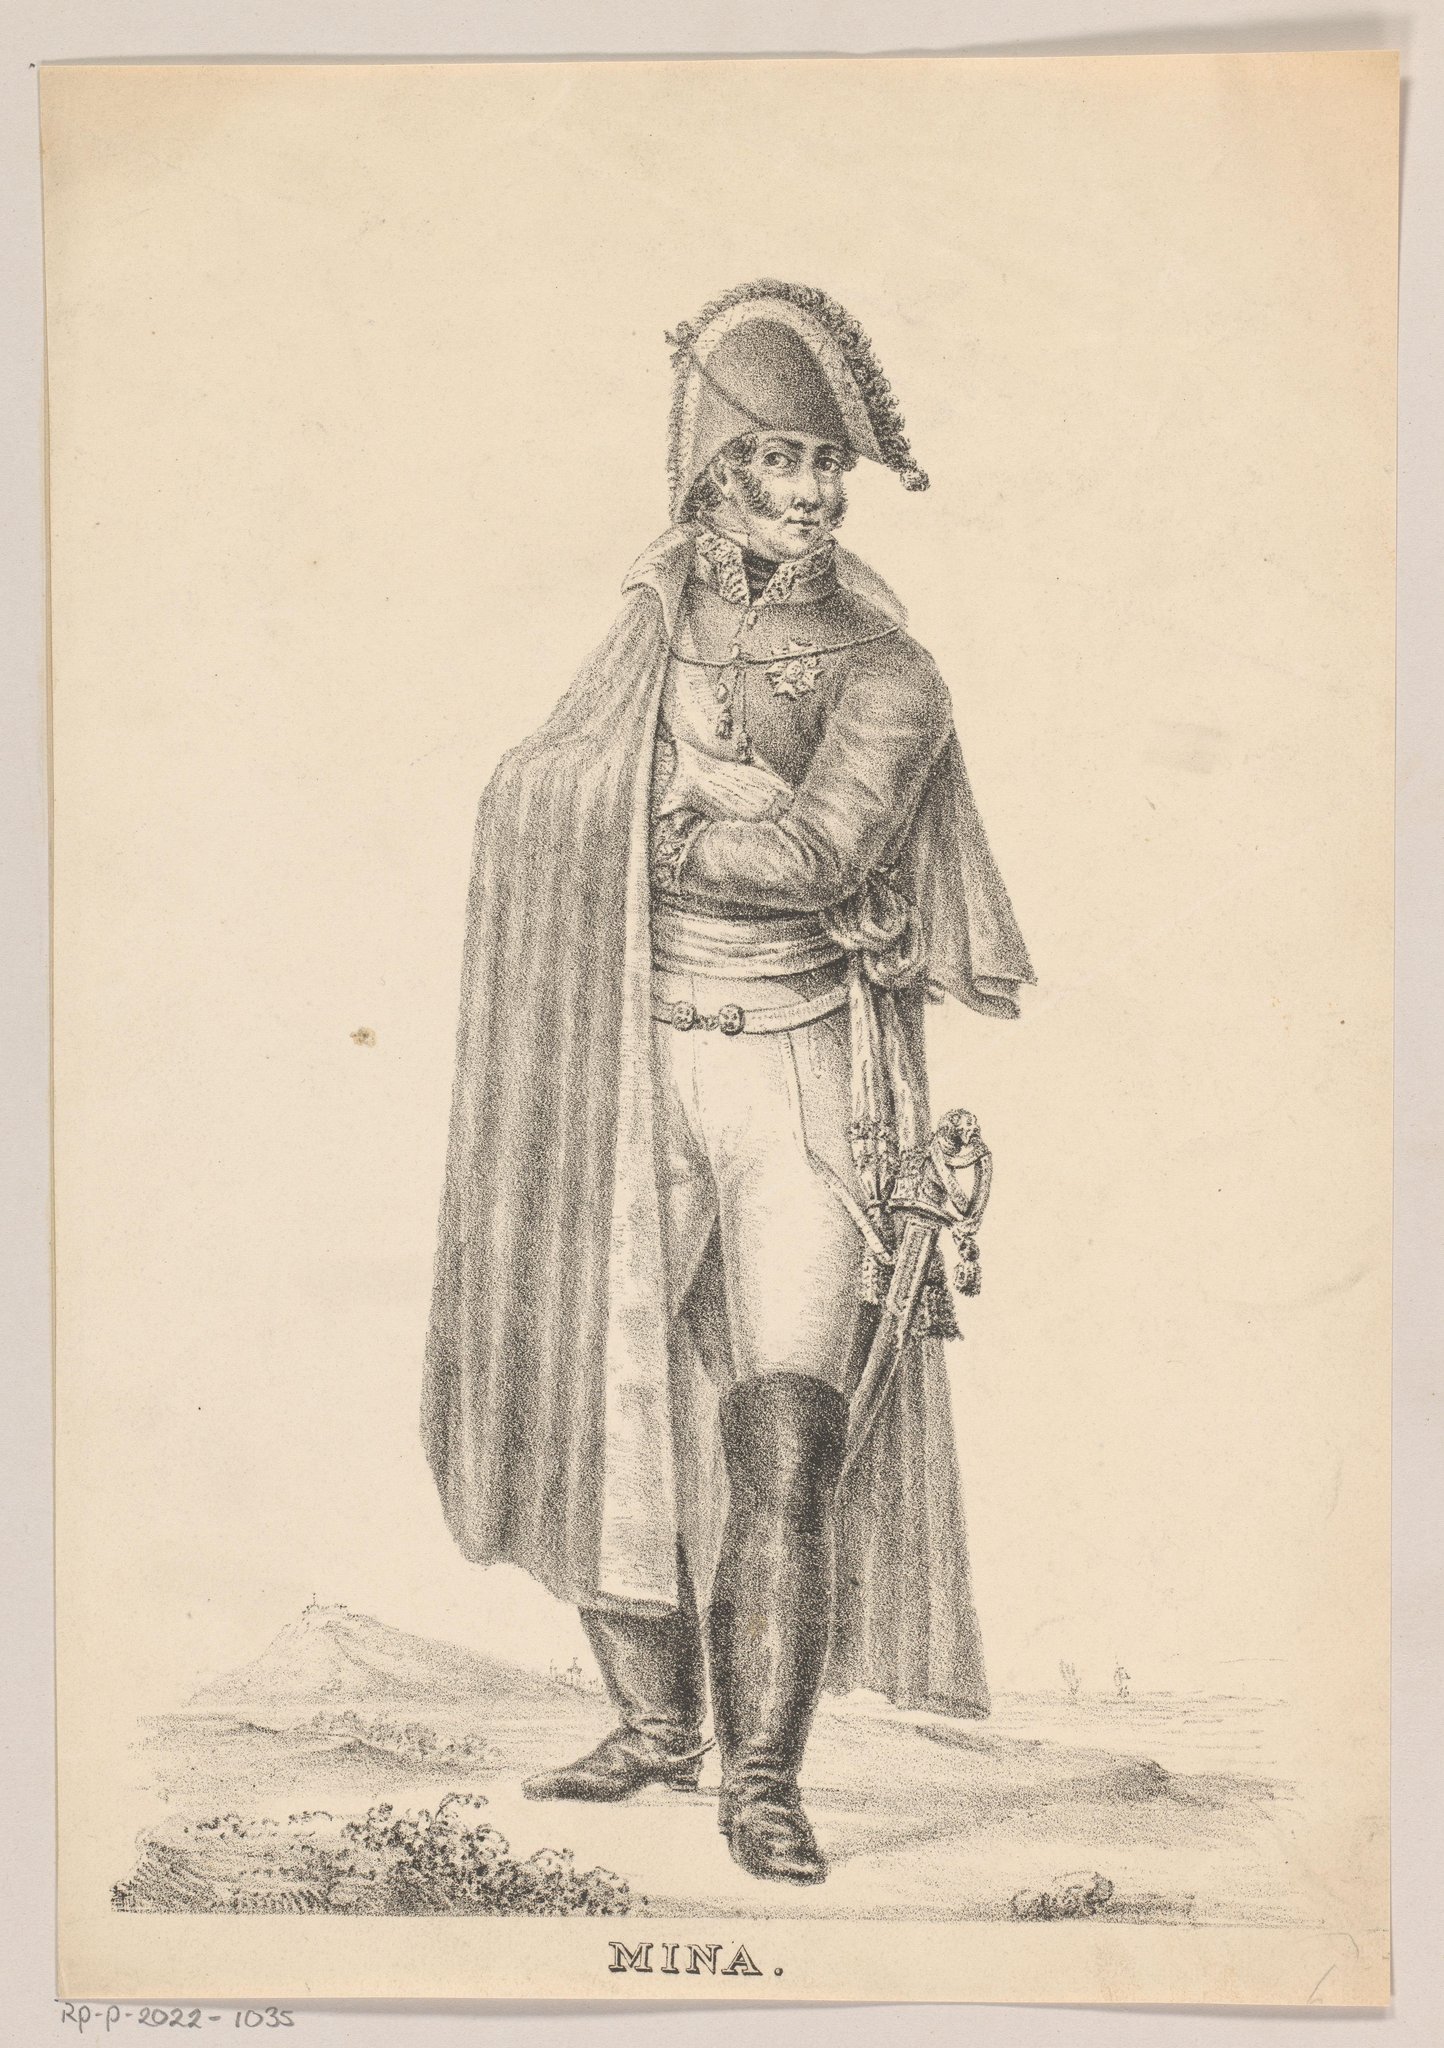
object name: print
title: Mina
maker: Anonymous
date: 1810-1900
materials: paper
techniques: lithograph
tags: commander-in-chief, general, marshal, historical persons